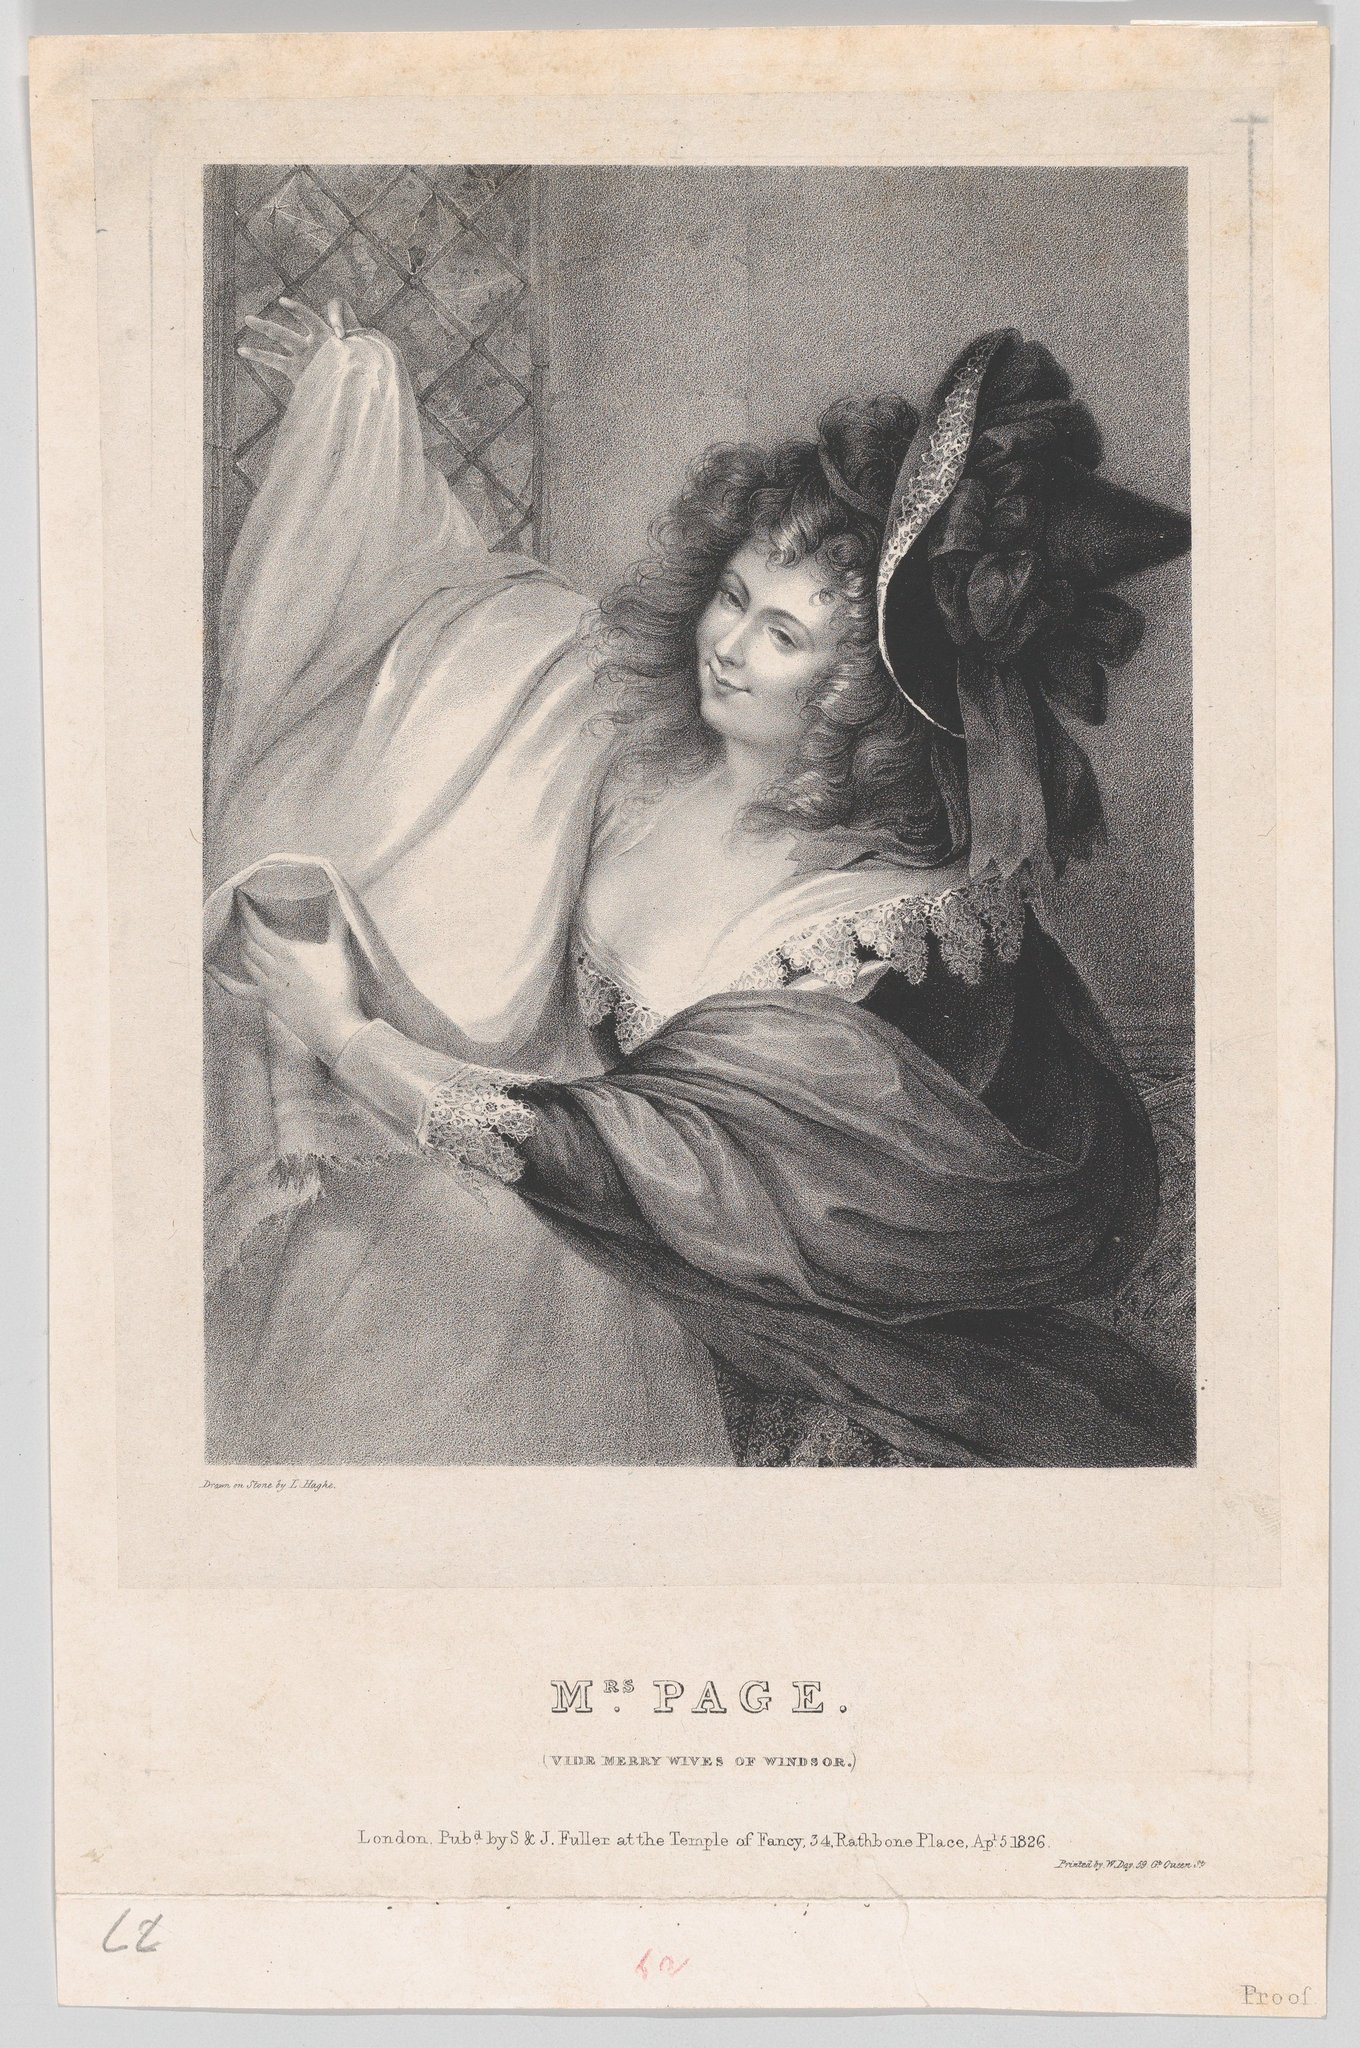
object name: print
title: Mrs. Page (Merry Wives of Windsor)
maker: louis haghe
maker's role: artist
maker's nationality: belgian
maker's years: 1806-1885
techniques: printmaking, lithograph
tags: shakespeare,women